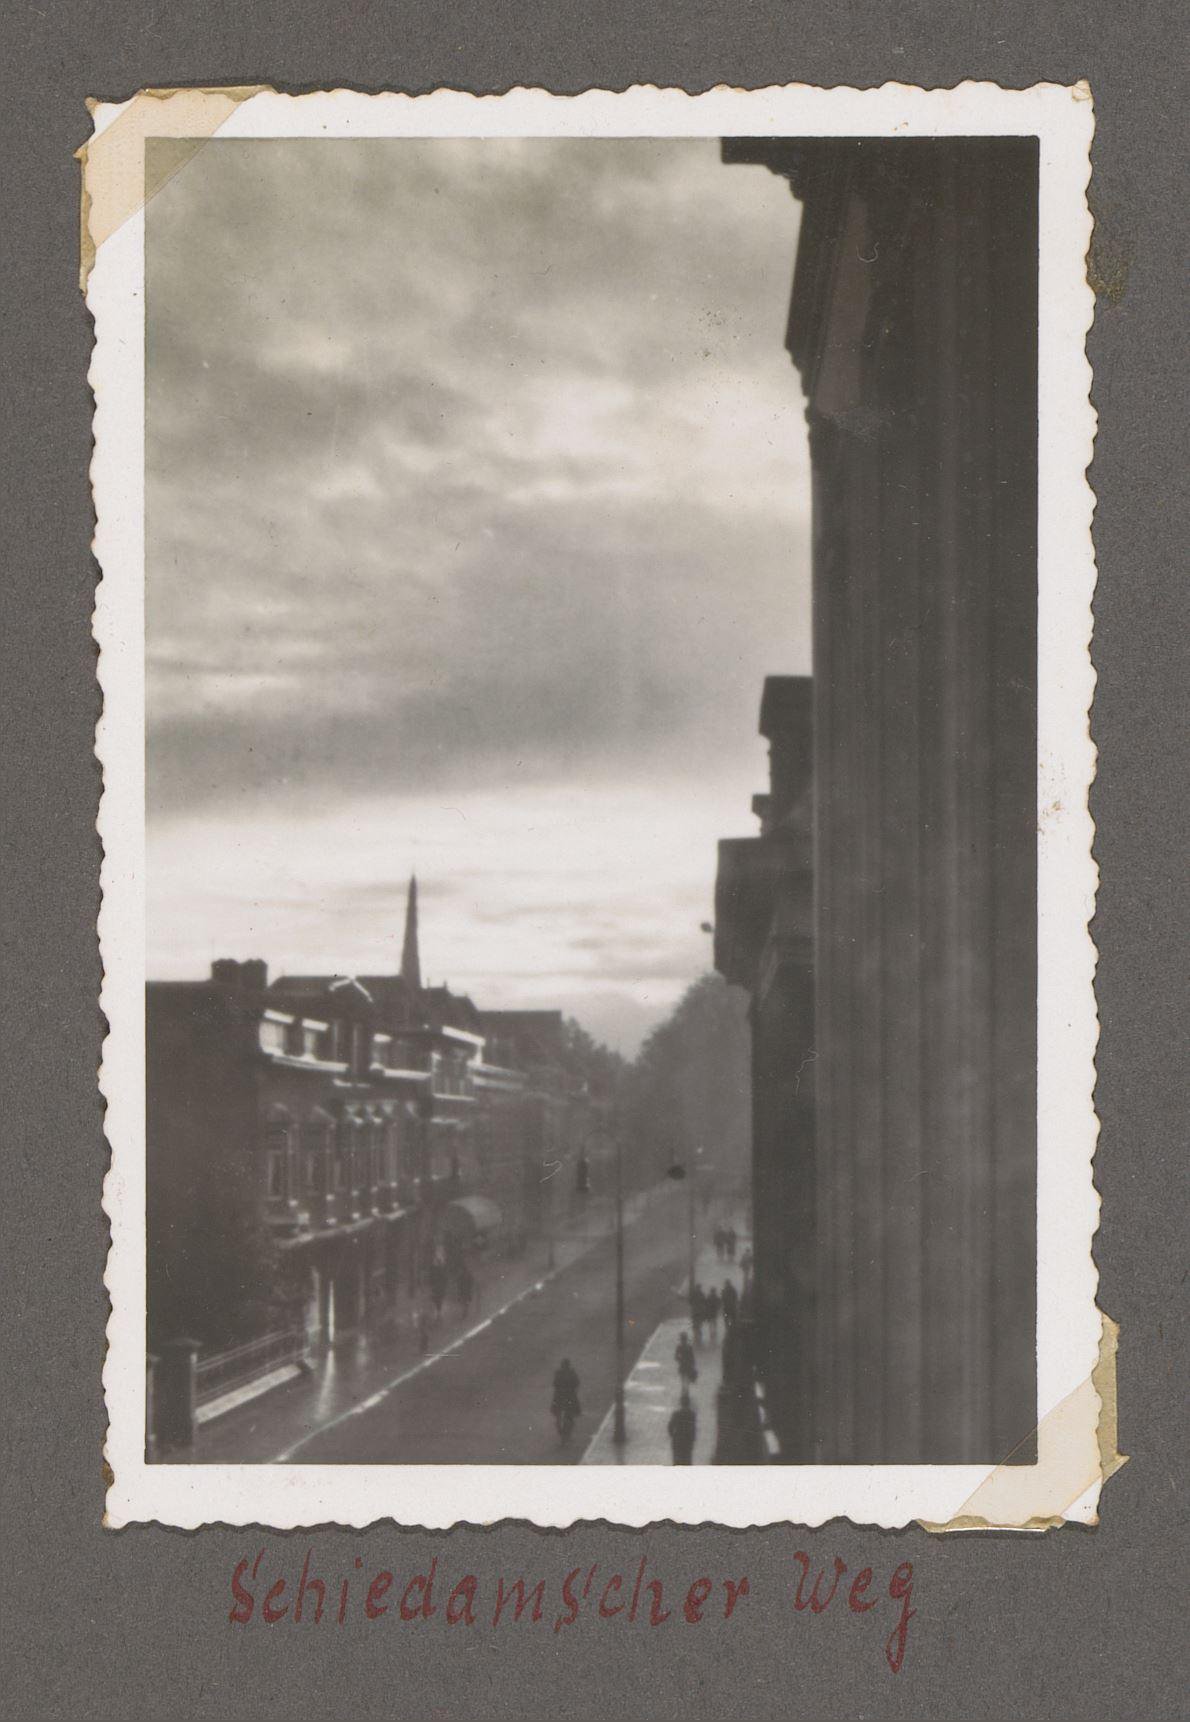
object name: photograph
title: Gezicht op de Schiedamseweg te Vlaardingen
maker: Anonymous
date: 1941-1945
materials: paper, photographic support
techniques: gelatin silver print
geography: vlaardingen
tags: street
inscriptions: annotation: ‘Schiedamscher Weg’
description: Gezicht op de Schiedamseweg te Vlaardingen in oostelijke richting, met aan het einde het Verploegh Chasséplein. Links vooraan de tuin en tuinhek van Villa IJzermans en geheel rechts de Dienststelle van het 9e Räumbootsflottille van de Duitse Kriegsmarine, van waaruit de foto is genomen.